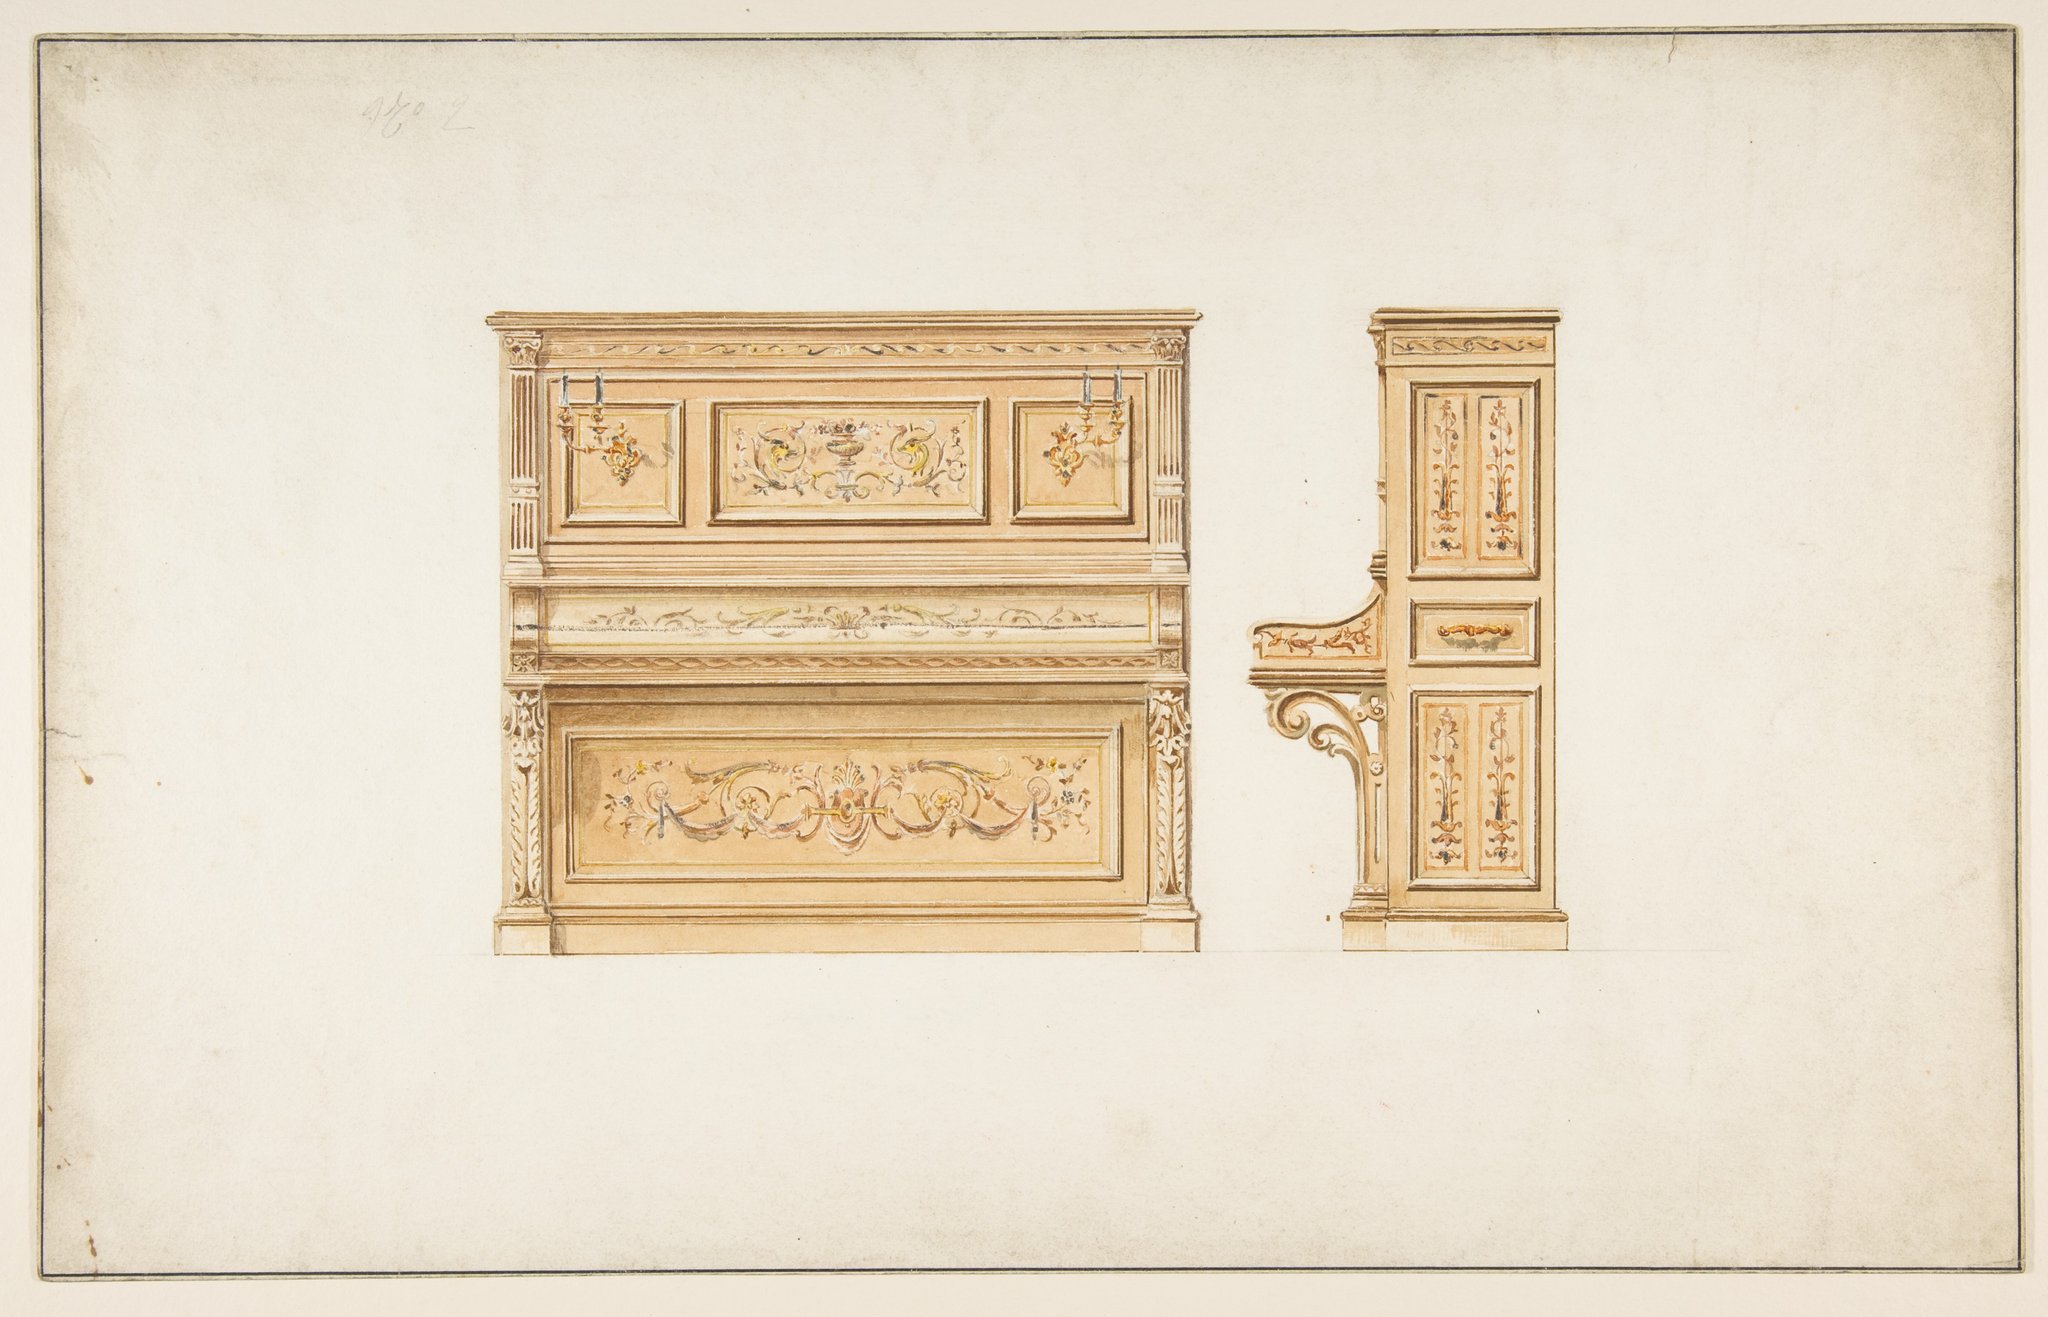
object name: drawing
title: Design for a Piano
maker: anonymous, french, 19th century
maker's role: artist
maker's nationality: french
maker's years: 1800-1900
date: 1801-1900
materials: watercolor, paper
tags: pianos